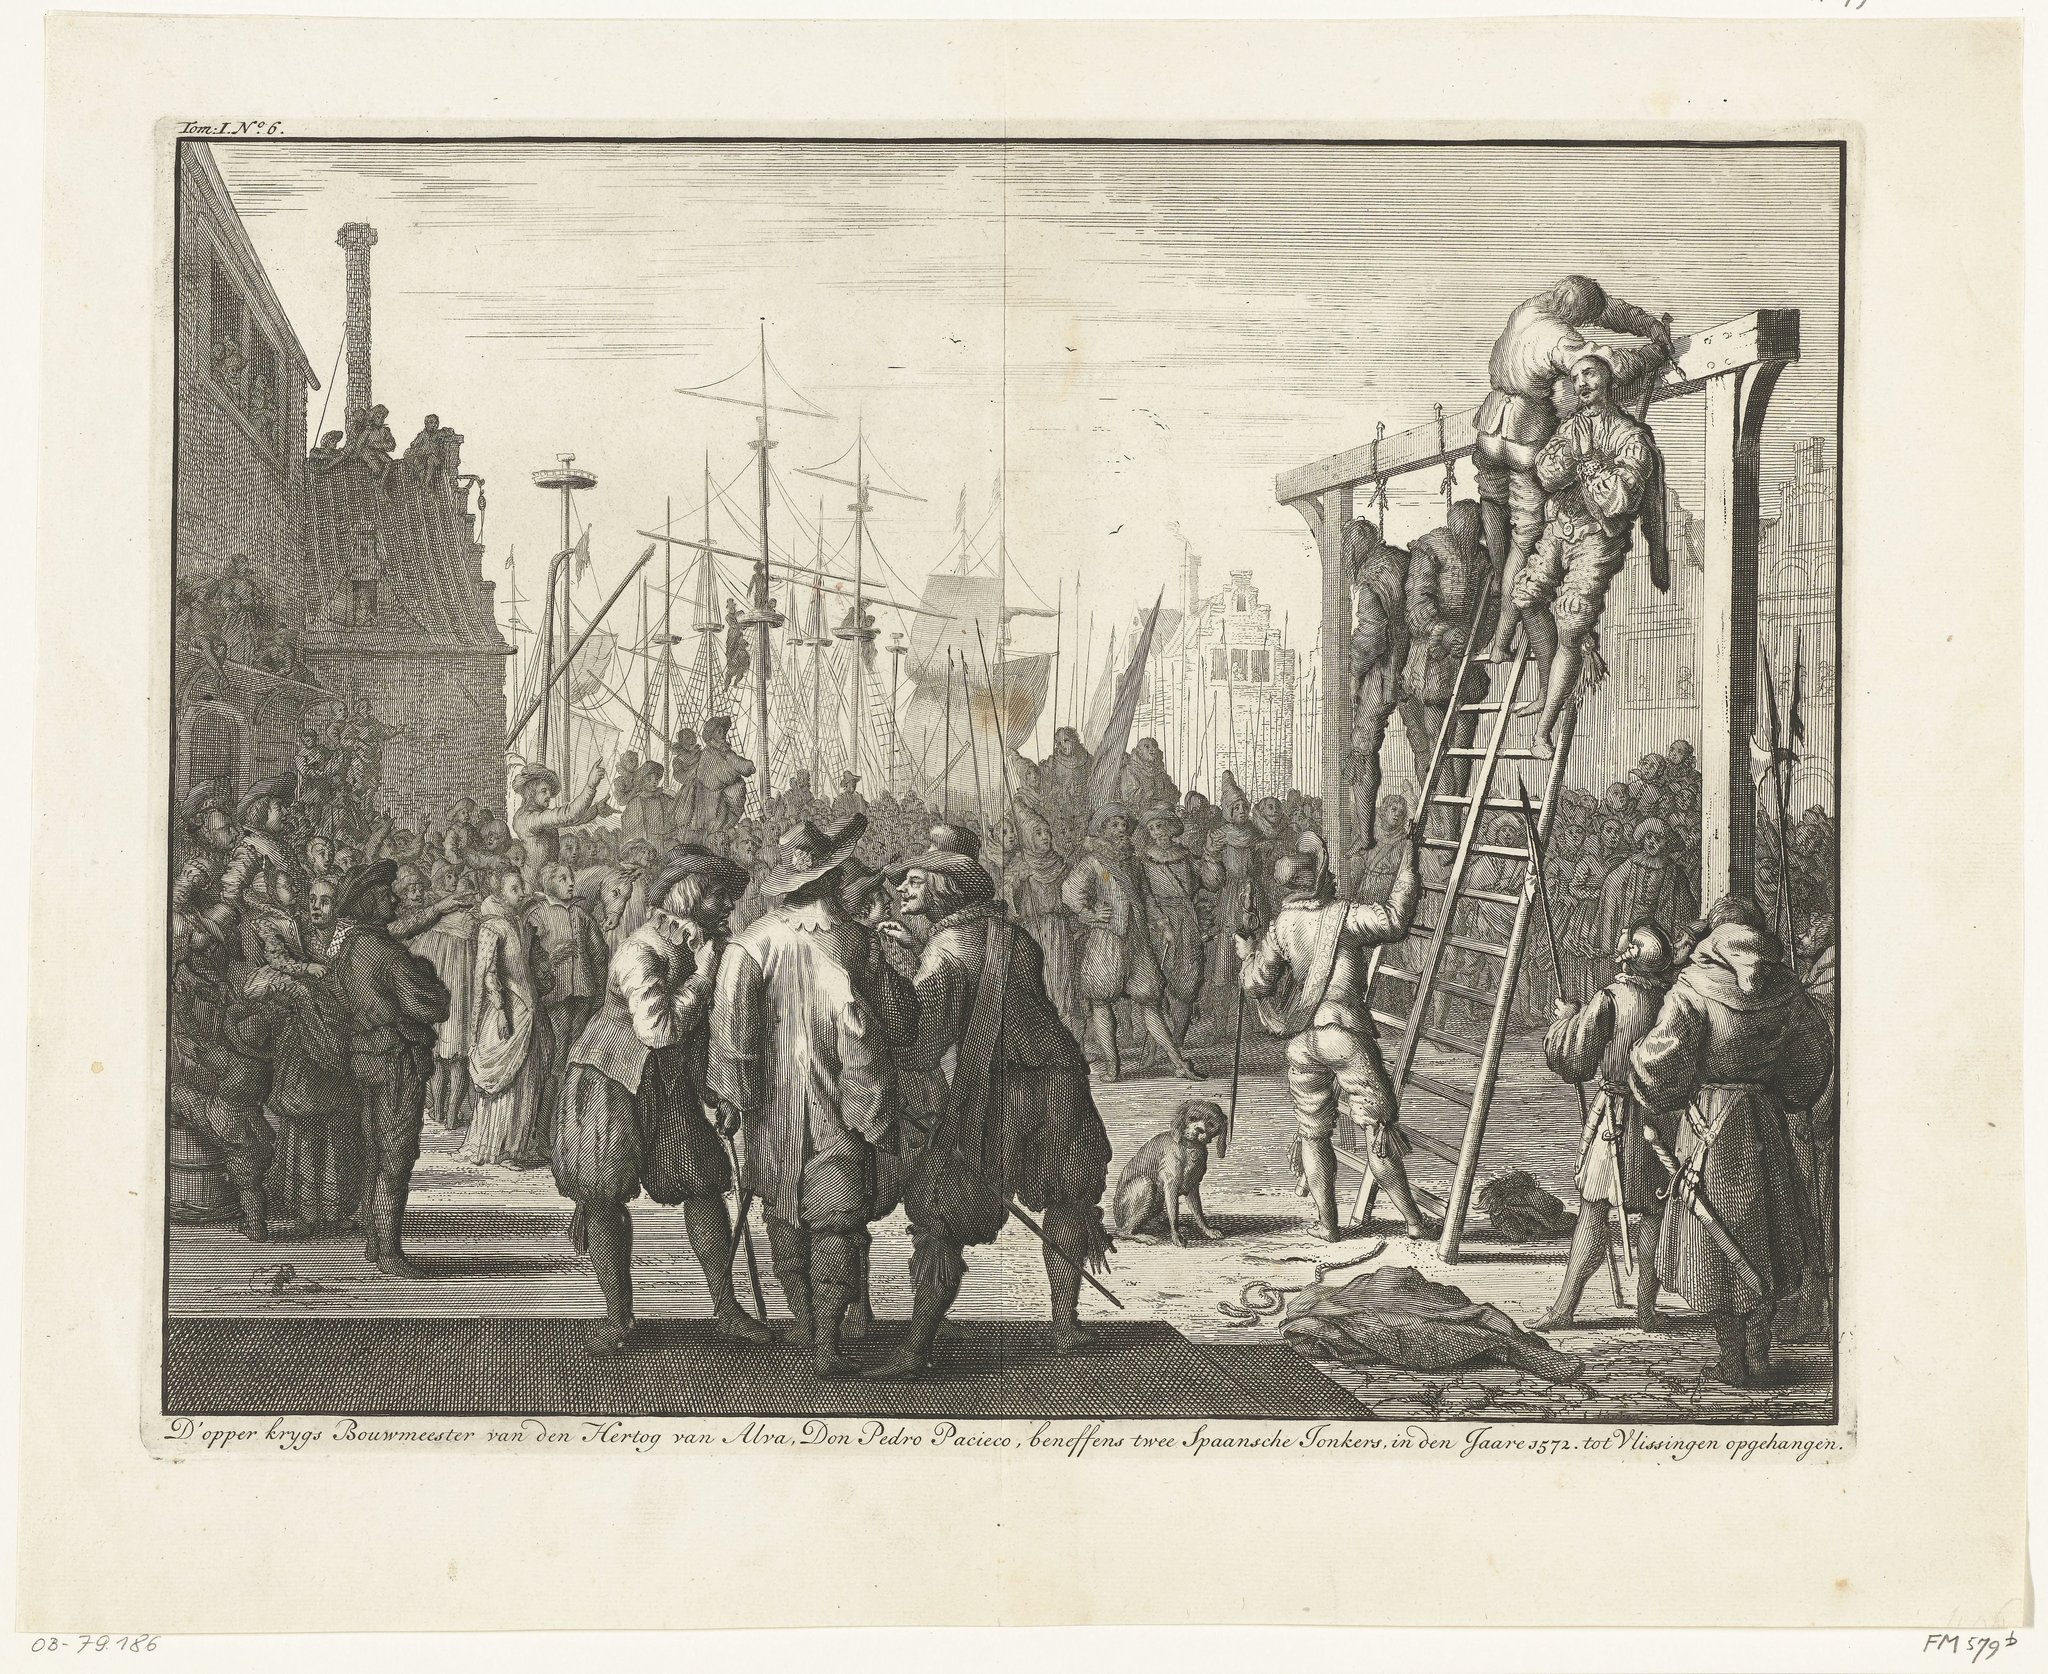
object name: print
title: D'opper krygs Bouwmeester van den Hertog van Alva, Don Pedro Pacieco, beneffens twee Spaansche Jonkers, in den Jaare 1572. tot Vlissingen opgehangen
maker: jan luyken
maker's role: draughtsman, print maker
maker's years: 1649-1712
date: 1677-1679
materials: paper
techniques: engraving, etching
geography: northern netherlands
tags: flushing, violent death by hanging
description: Illustratie gebruikt in: J. le Clerc, Geschiedenissen der Vereenigde Nederlanden, sedert den aanvang van die Republyk tot op den Vrede van Utrecht in 't jaar 1713 en het Tractaat van Barriere in 't jaar 1715 gesloten, Z. Chatelain, Amsterdam 1730, 3 delen, Tom. I, No. 6.